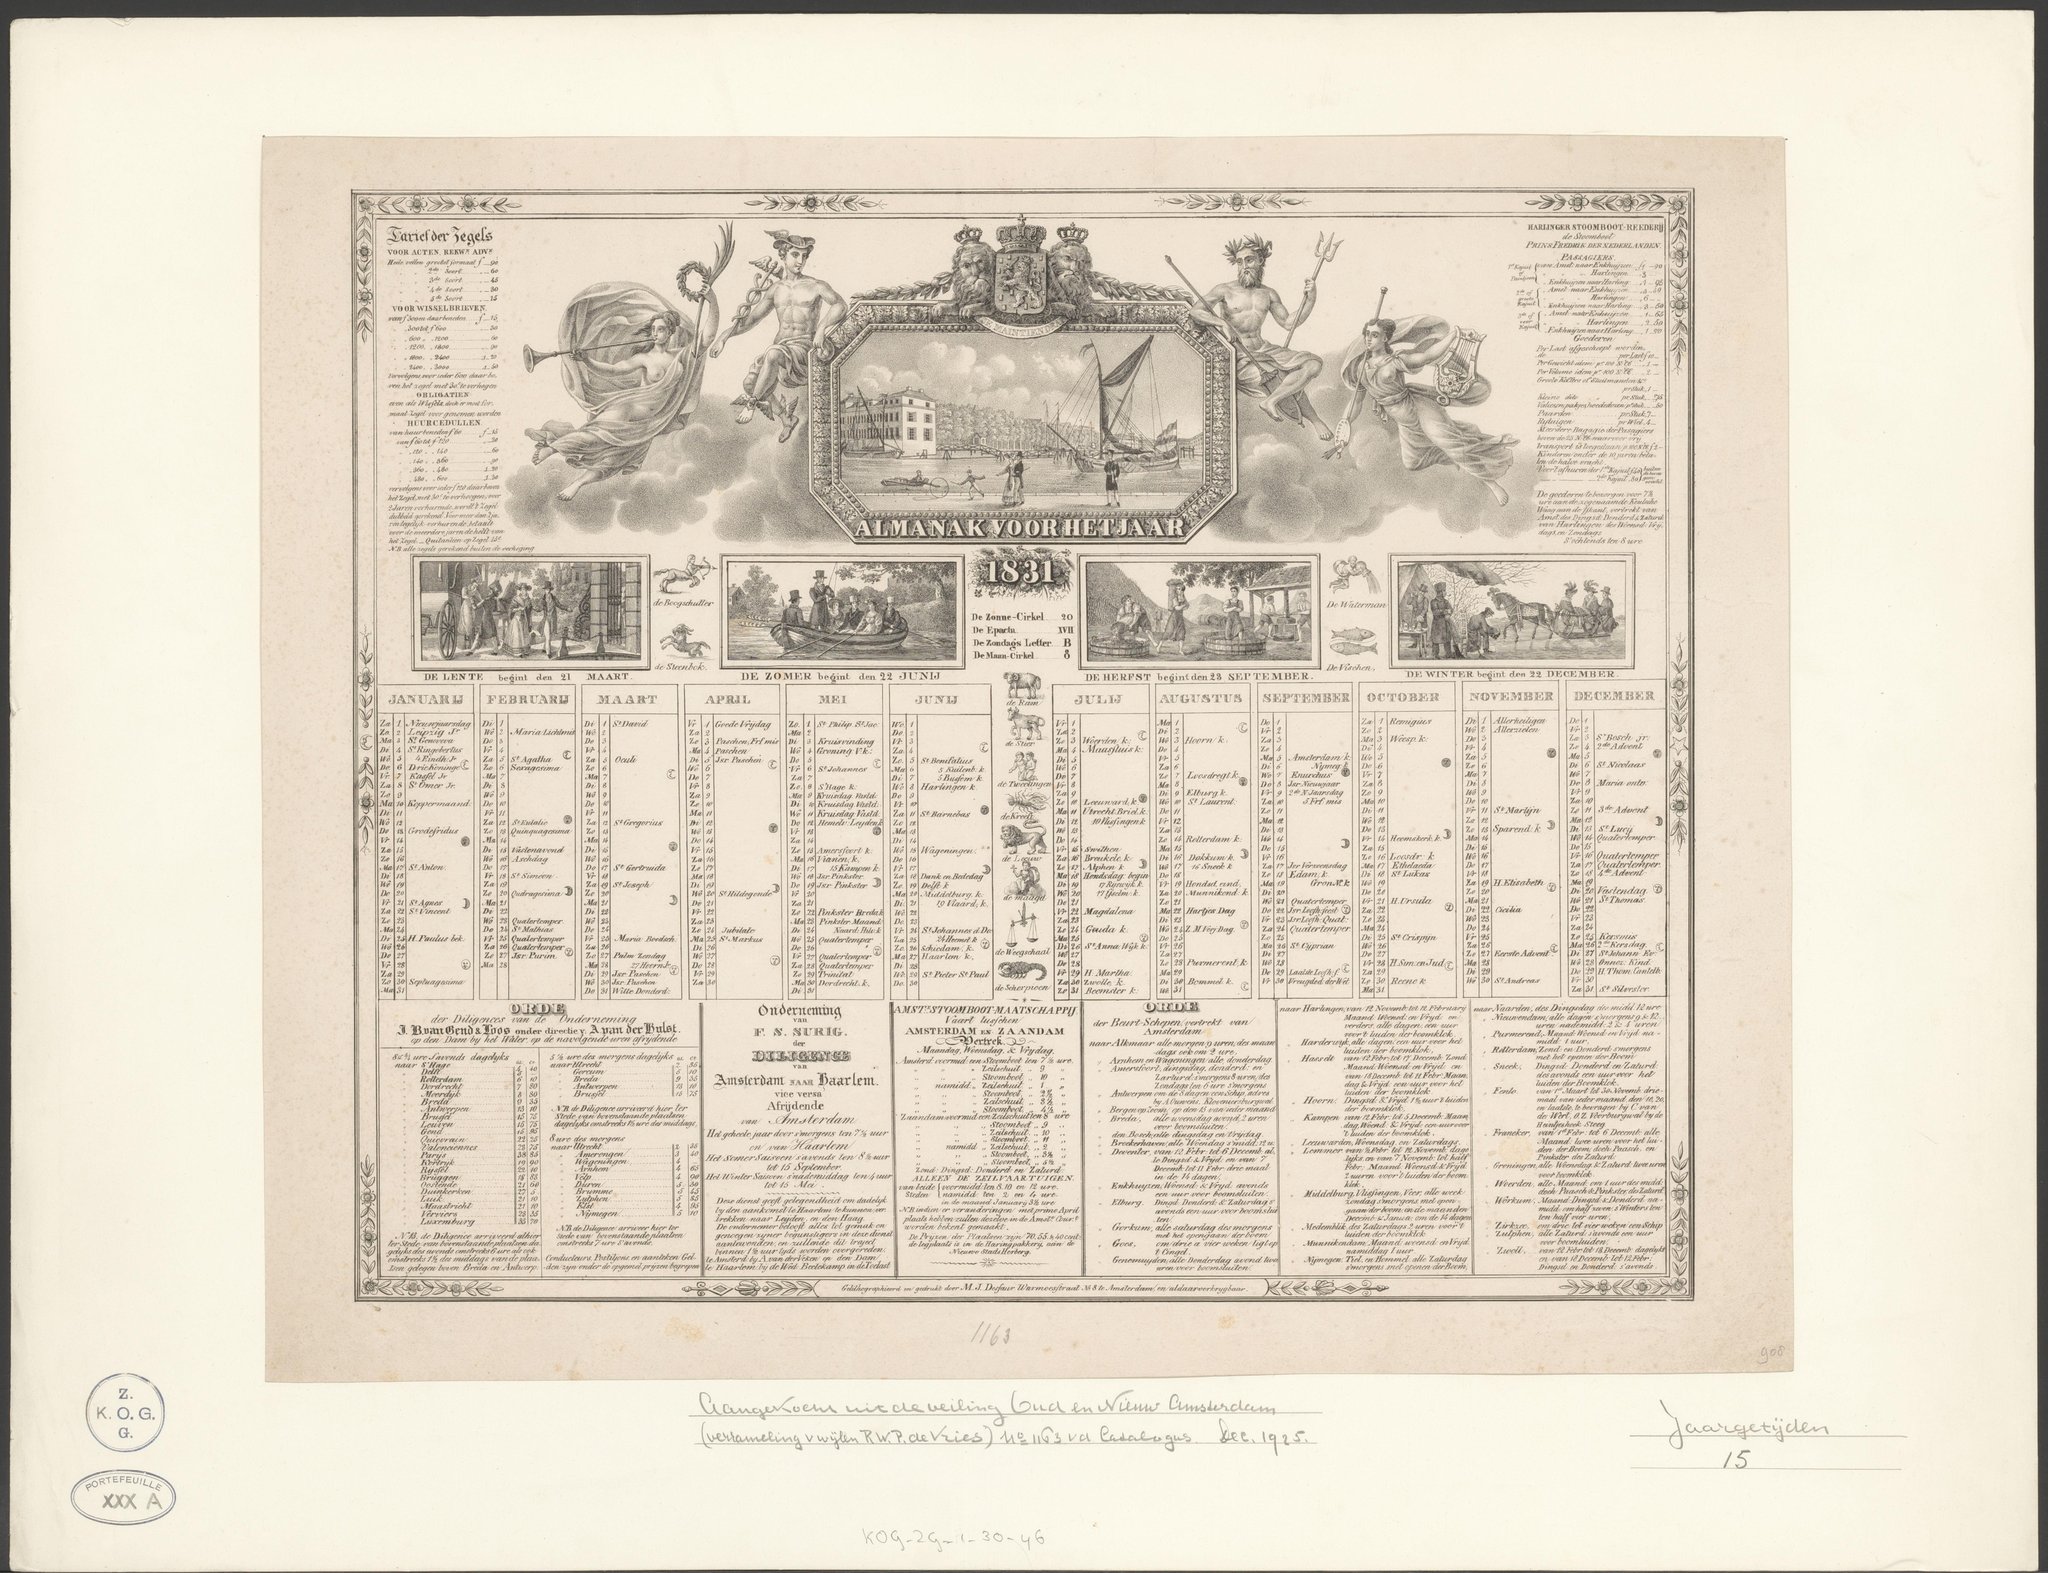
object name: print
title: Almanak voor 1831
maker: morris jacob dessaur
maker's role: print maker, printer, publisher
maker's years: 1799-1876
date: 1829-1831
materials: paper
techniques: lithograph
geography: amsterdam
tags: (story of) neptune (poseidon), calendar, almanac, (story of) mercury (hermes)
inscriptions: collector's mark: Lugt 1641, stamp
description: Onderwerpsrubrieken binnen de Atlas Zeden en Gewoonten: Zeden en Gewoonten in engeren zin. Volksleven. Zinnebeeldige voorstellingen uit het volkleven op serieprenten. Jaargetijden.